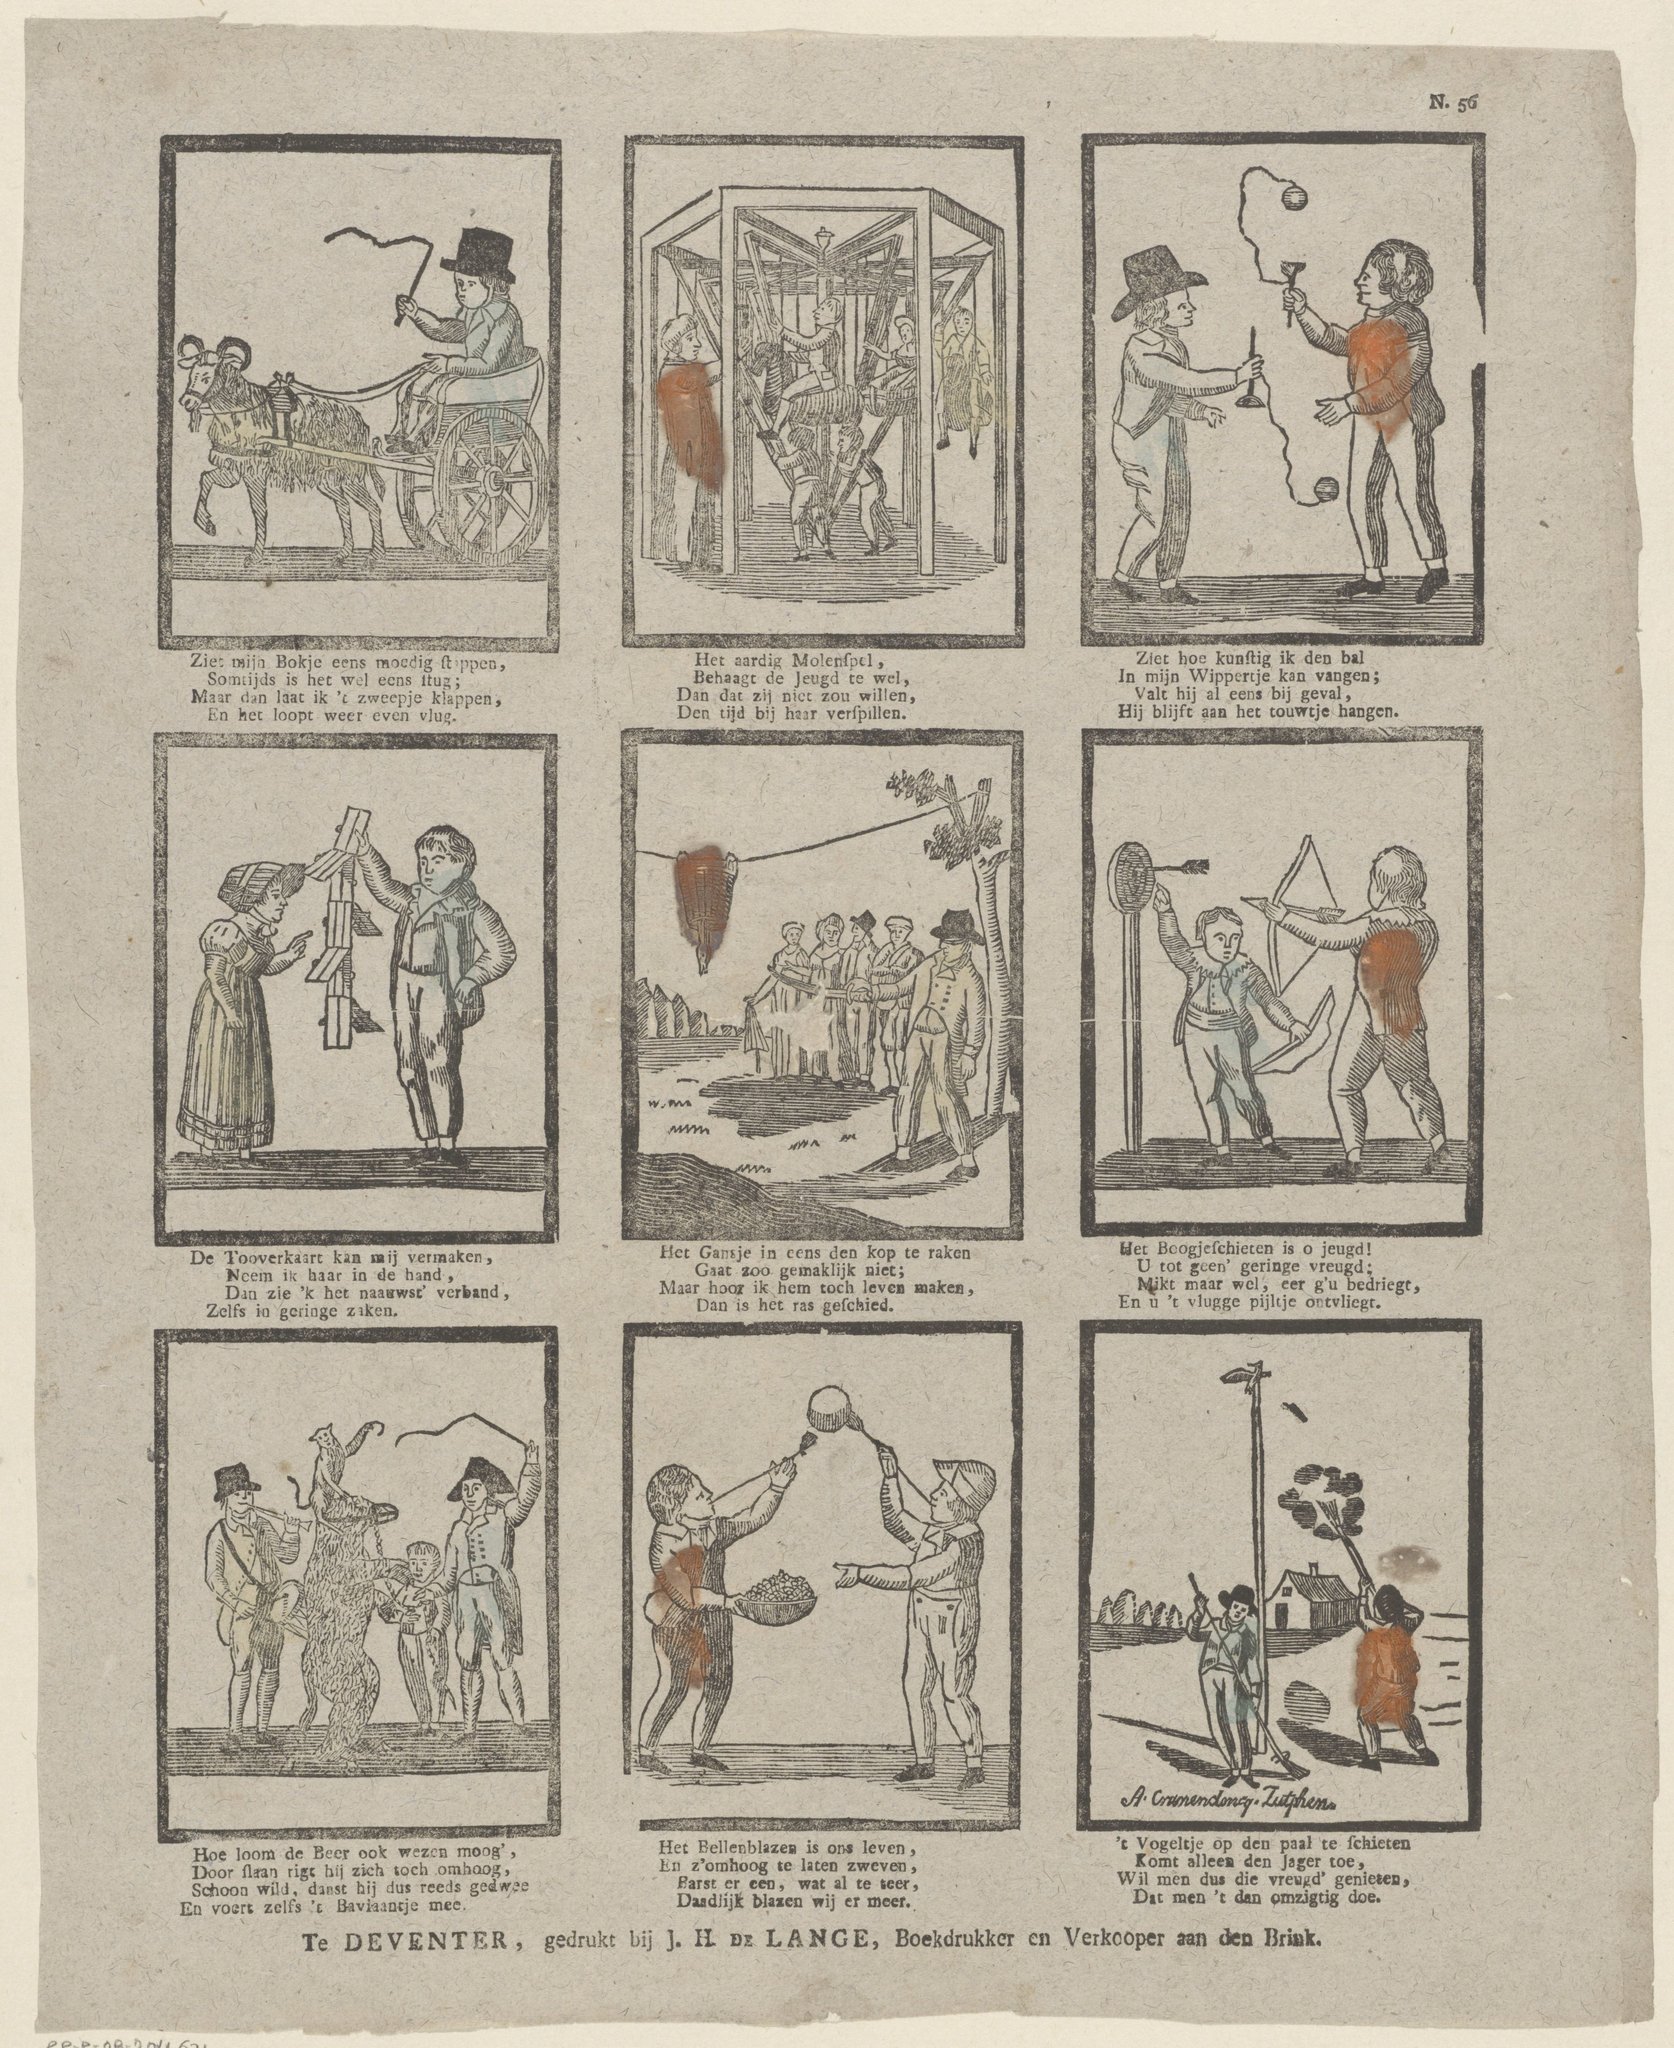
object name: print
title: Kinderspelen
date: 1787-1822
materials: paper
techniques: colour, letterpress printing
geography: zutphen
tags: bubble-blowing (children's games and plays), children's games and plays, games using special objects (marbles, top, hoop, etc.)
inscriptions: collector's mark: Lugt 2760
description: Blad met 12 voorstellingen van kinderspelen, zoals schieten met pijl-en-boog en bellenblazen. Onder elke voorstelling een vierregelig vers. Genummerd rechtsboven: N. 56.